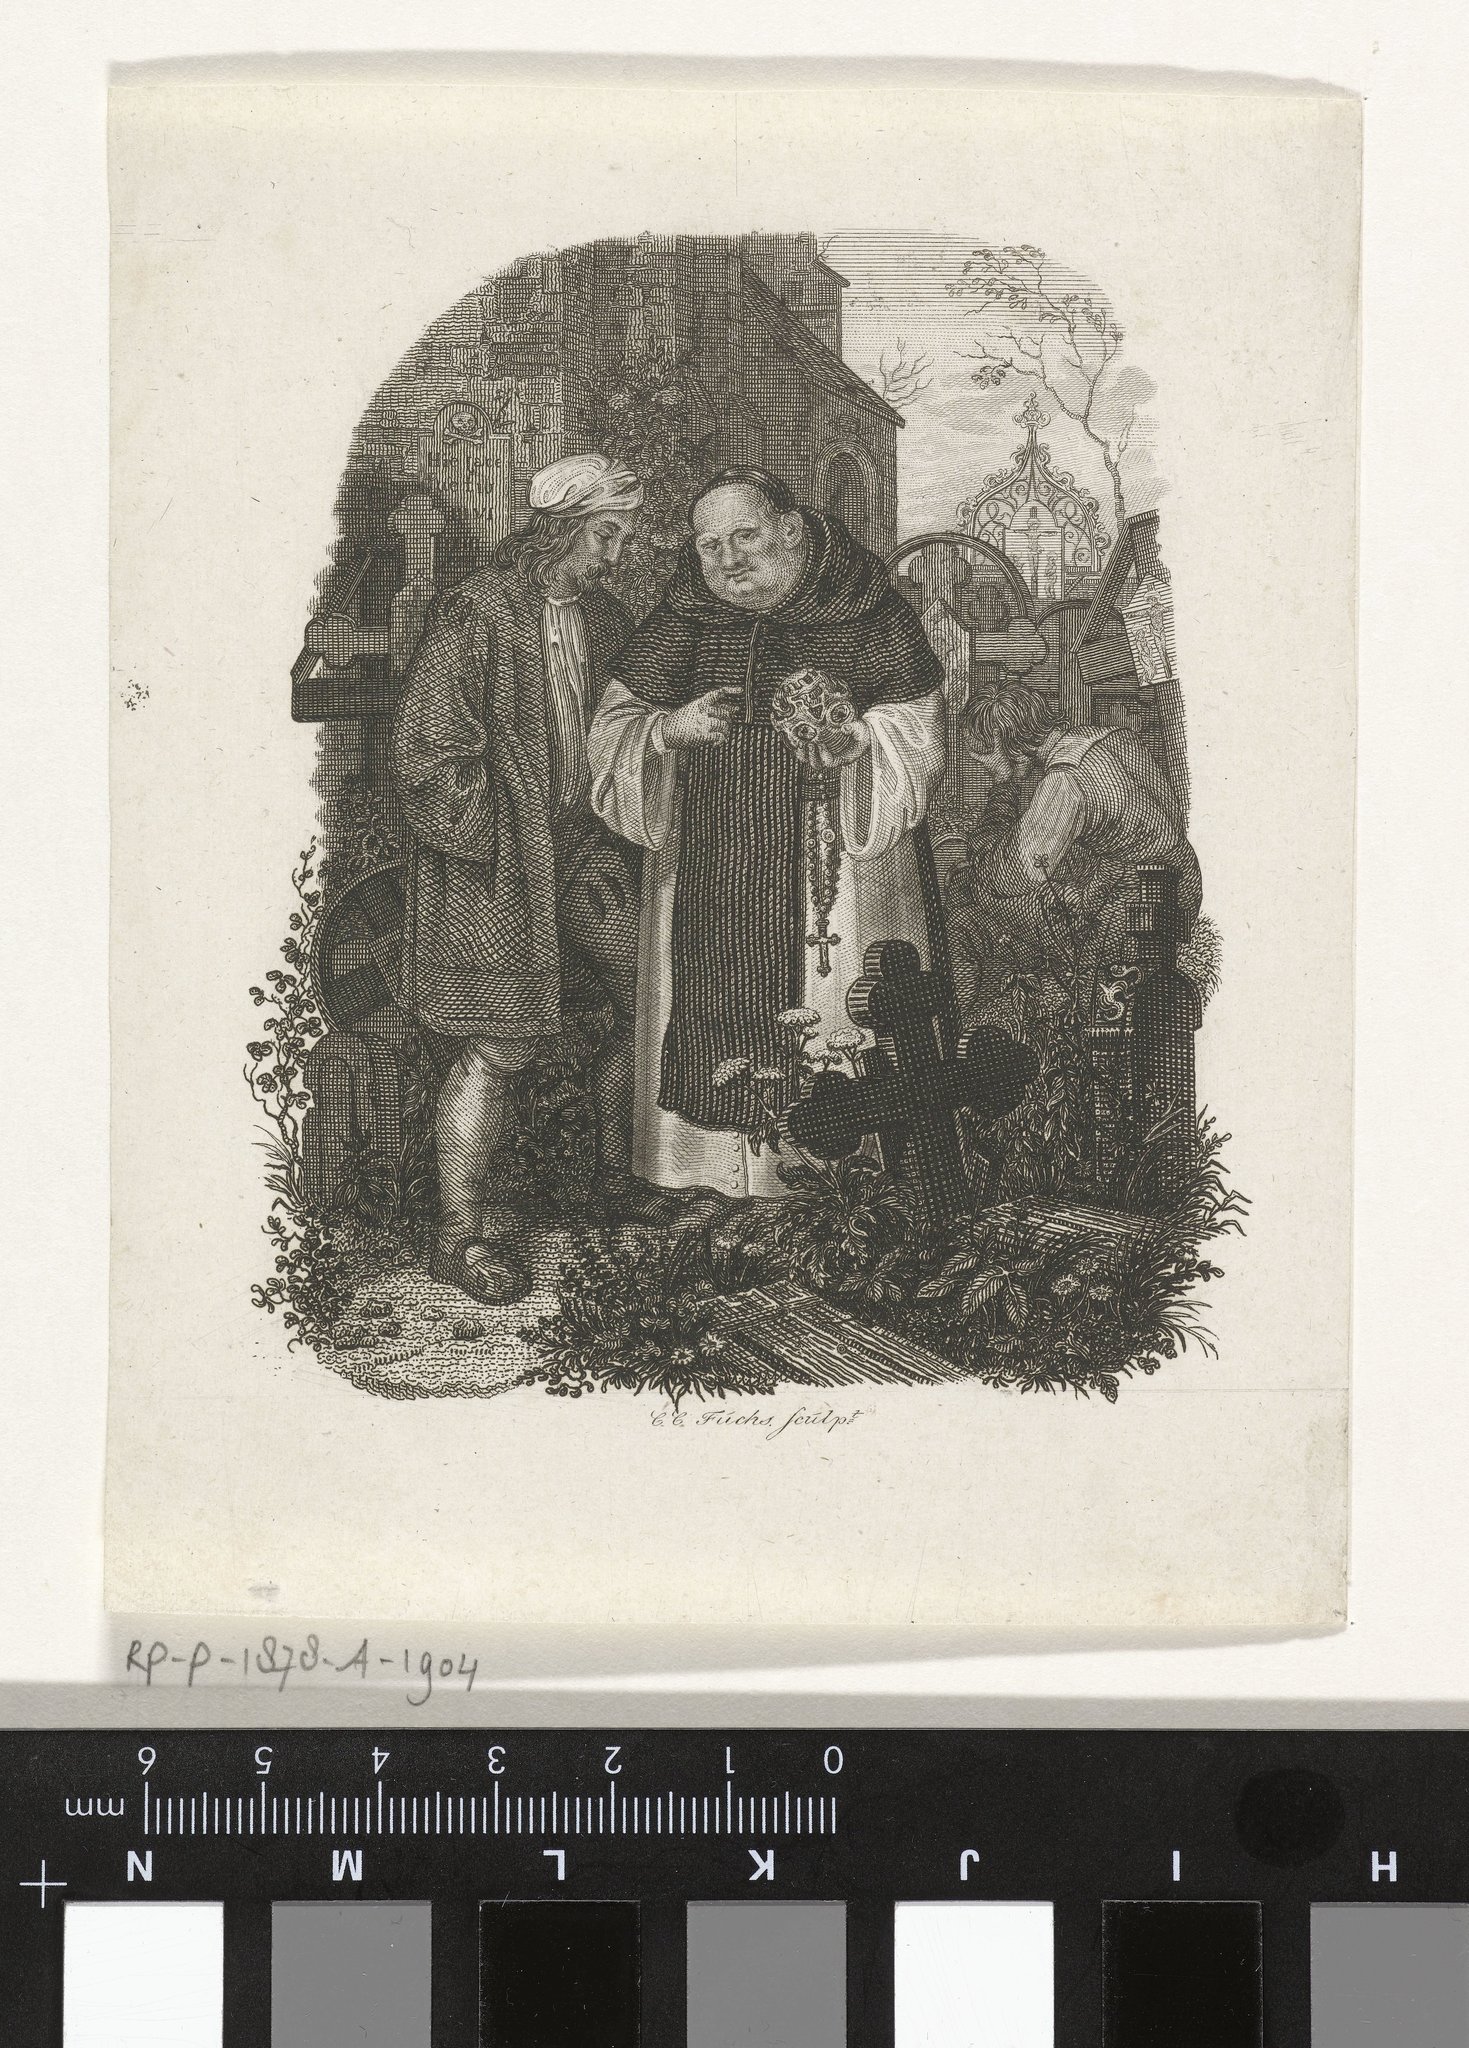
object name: print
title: Het kerkhof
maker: karel christiaan fuchs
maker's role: draughtsman, print maker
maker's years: 1792-1855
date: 1802-1855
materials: paper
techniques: etching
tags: churchyard, cemetery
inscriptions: collector's mark: Lugt 2228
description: Een katholieke geestelijke en twee mannen op een kerkhof. De geestelijke wijst de man naast hem op het doodshoofd in zijn handen. Op de achtergrond rouwt een man bij een graf.